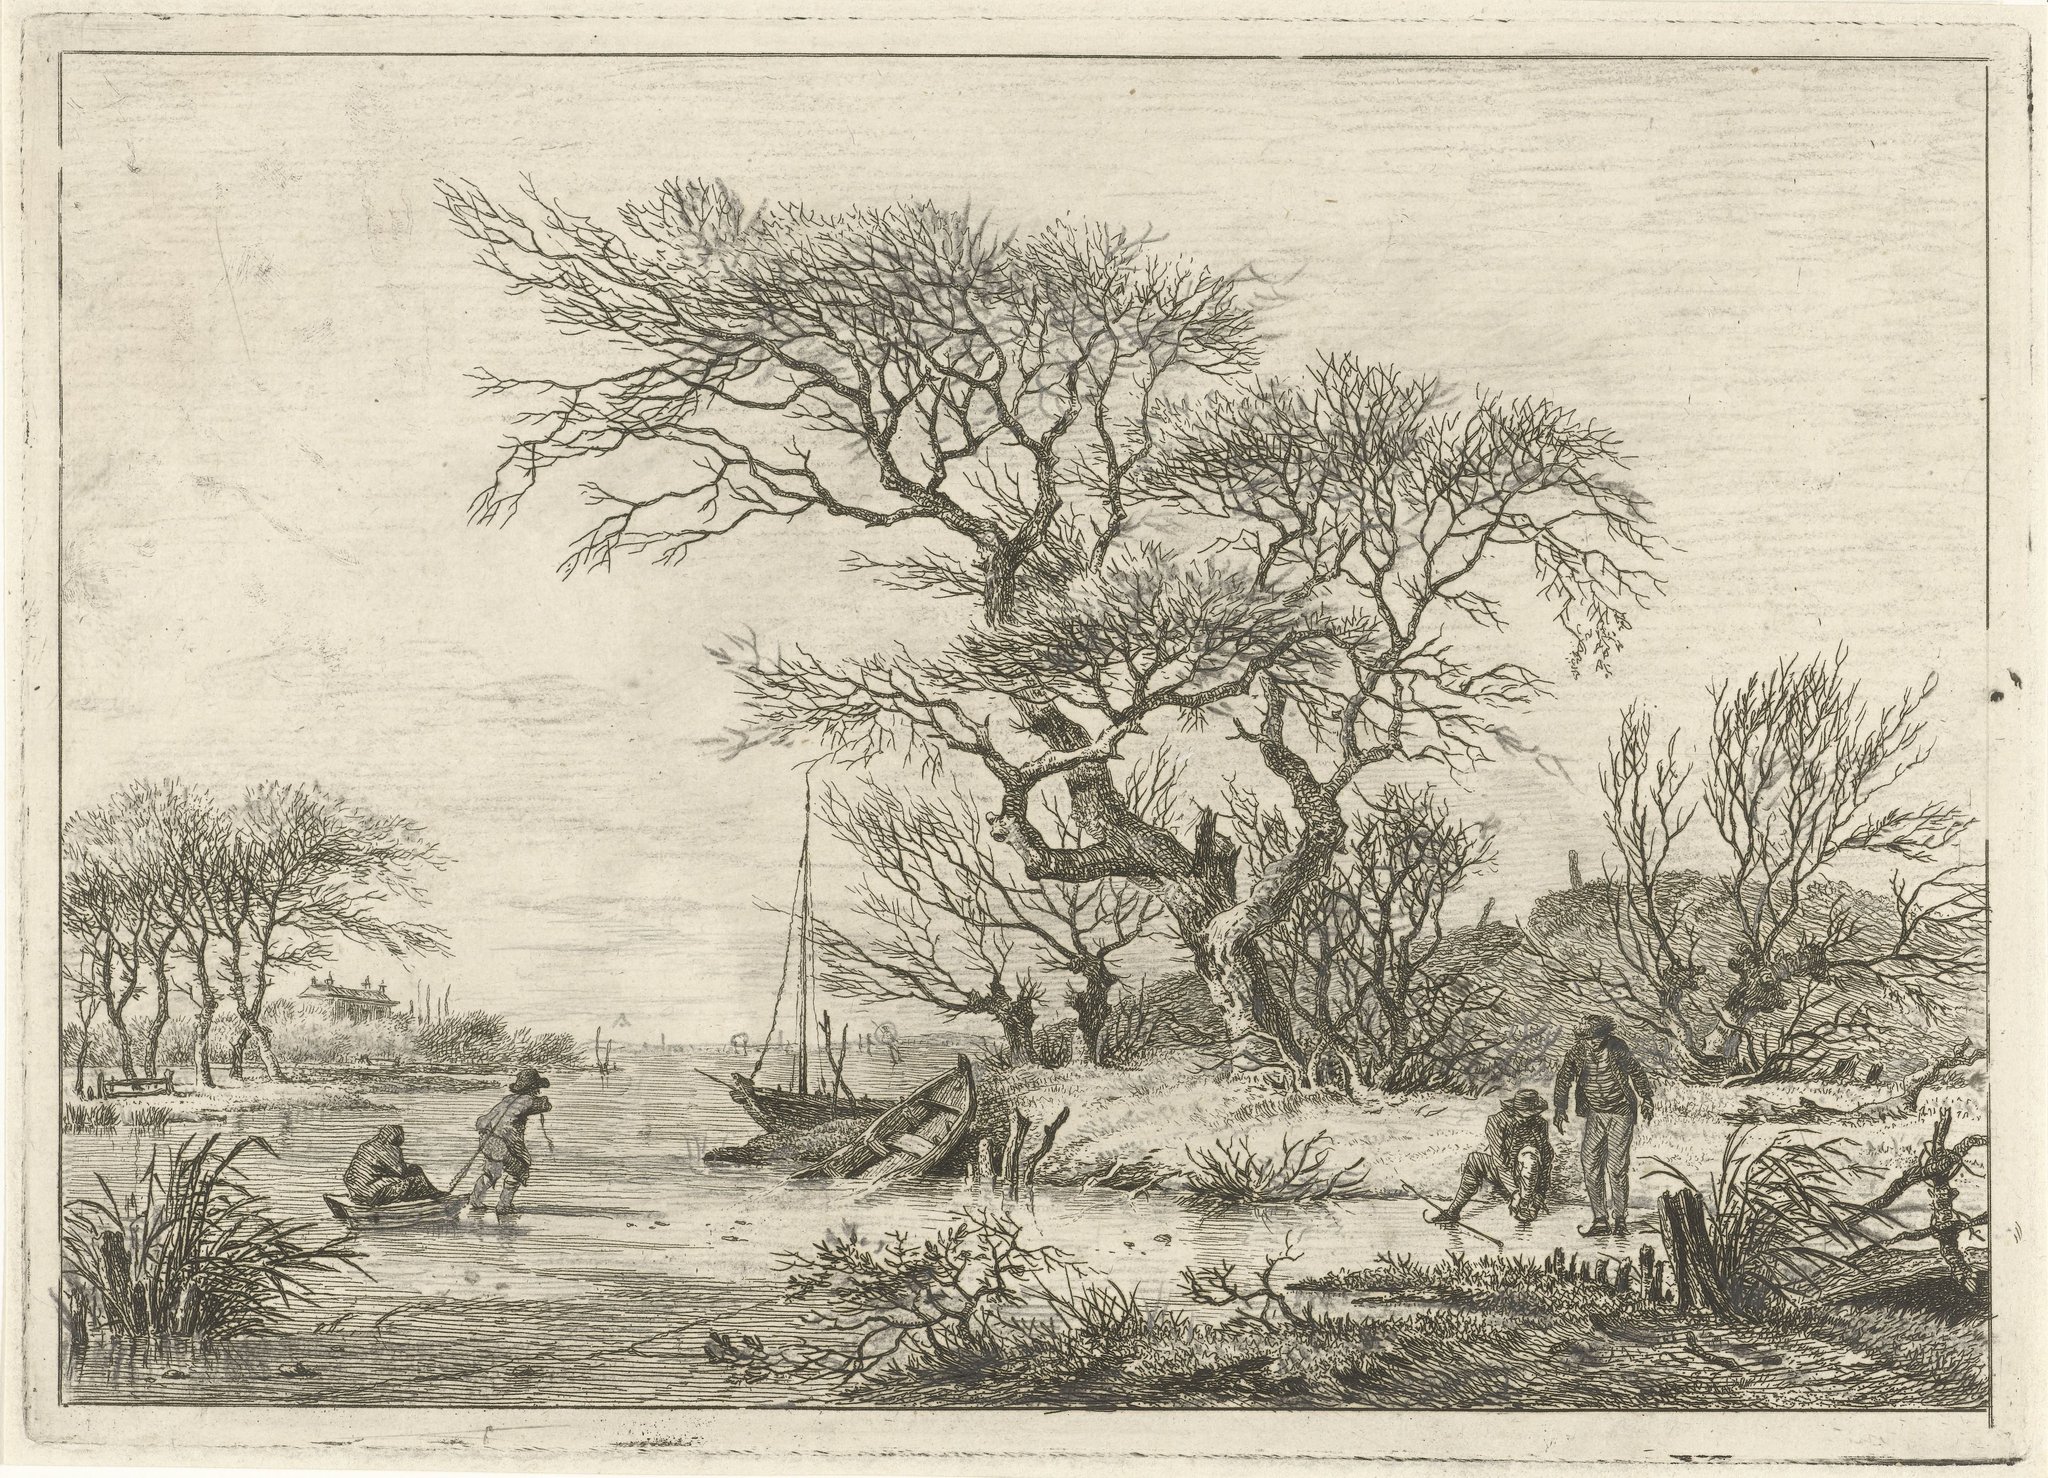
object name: print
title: Winterlandschap met schaatsers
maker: hermanus fock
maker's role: conservator, draughtsman, painter, print maker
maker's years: 1766-1822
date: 1781-1822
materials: paper, pencil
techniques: etching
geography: amsterdam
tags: winter landscape; landscape symbolizing winter (the four seasons of the year), skates (winter sports) (+ out of doors (sports, games, etc.))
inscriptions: collector's mark: Lugt 2228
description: Gezicht op een winterlandschap met een dichtgevroren rivier. Op het ijs schaatsers en een slee. Op de oever is een man zijn schaatsen aan het onderbinden.